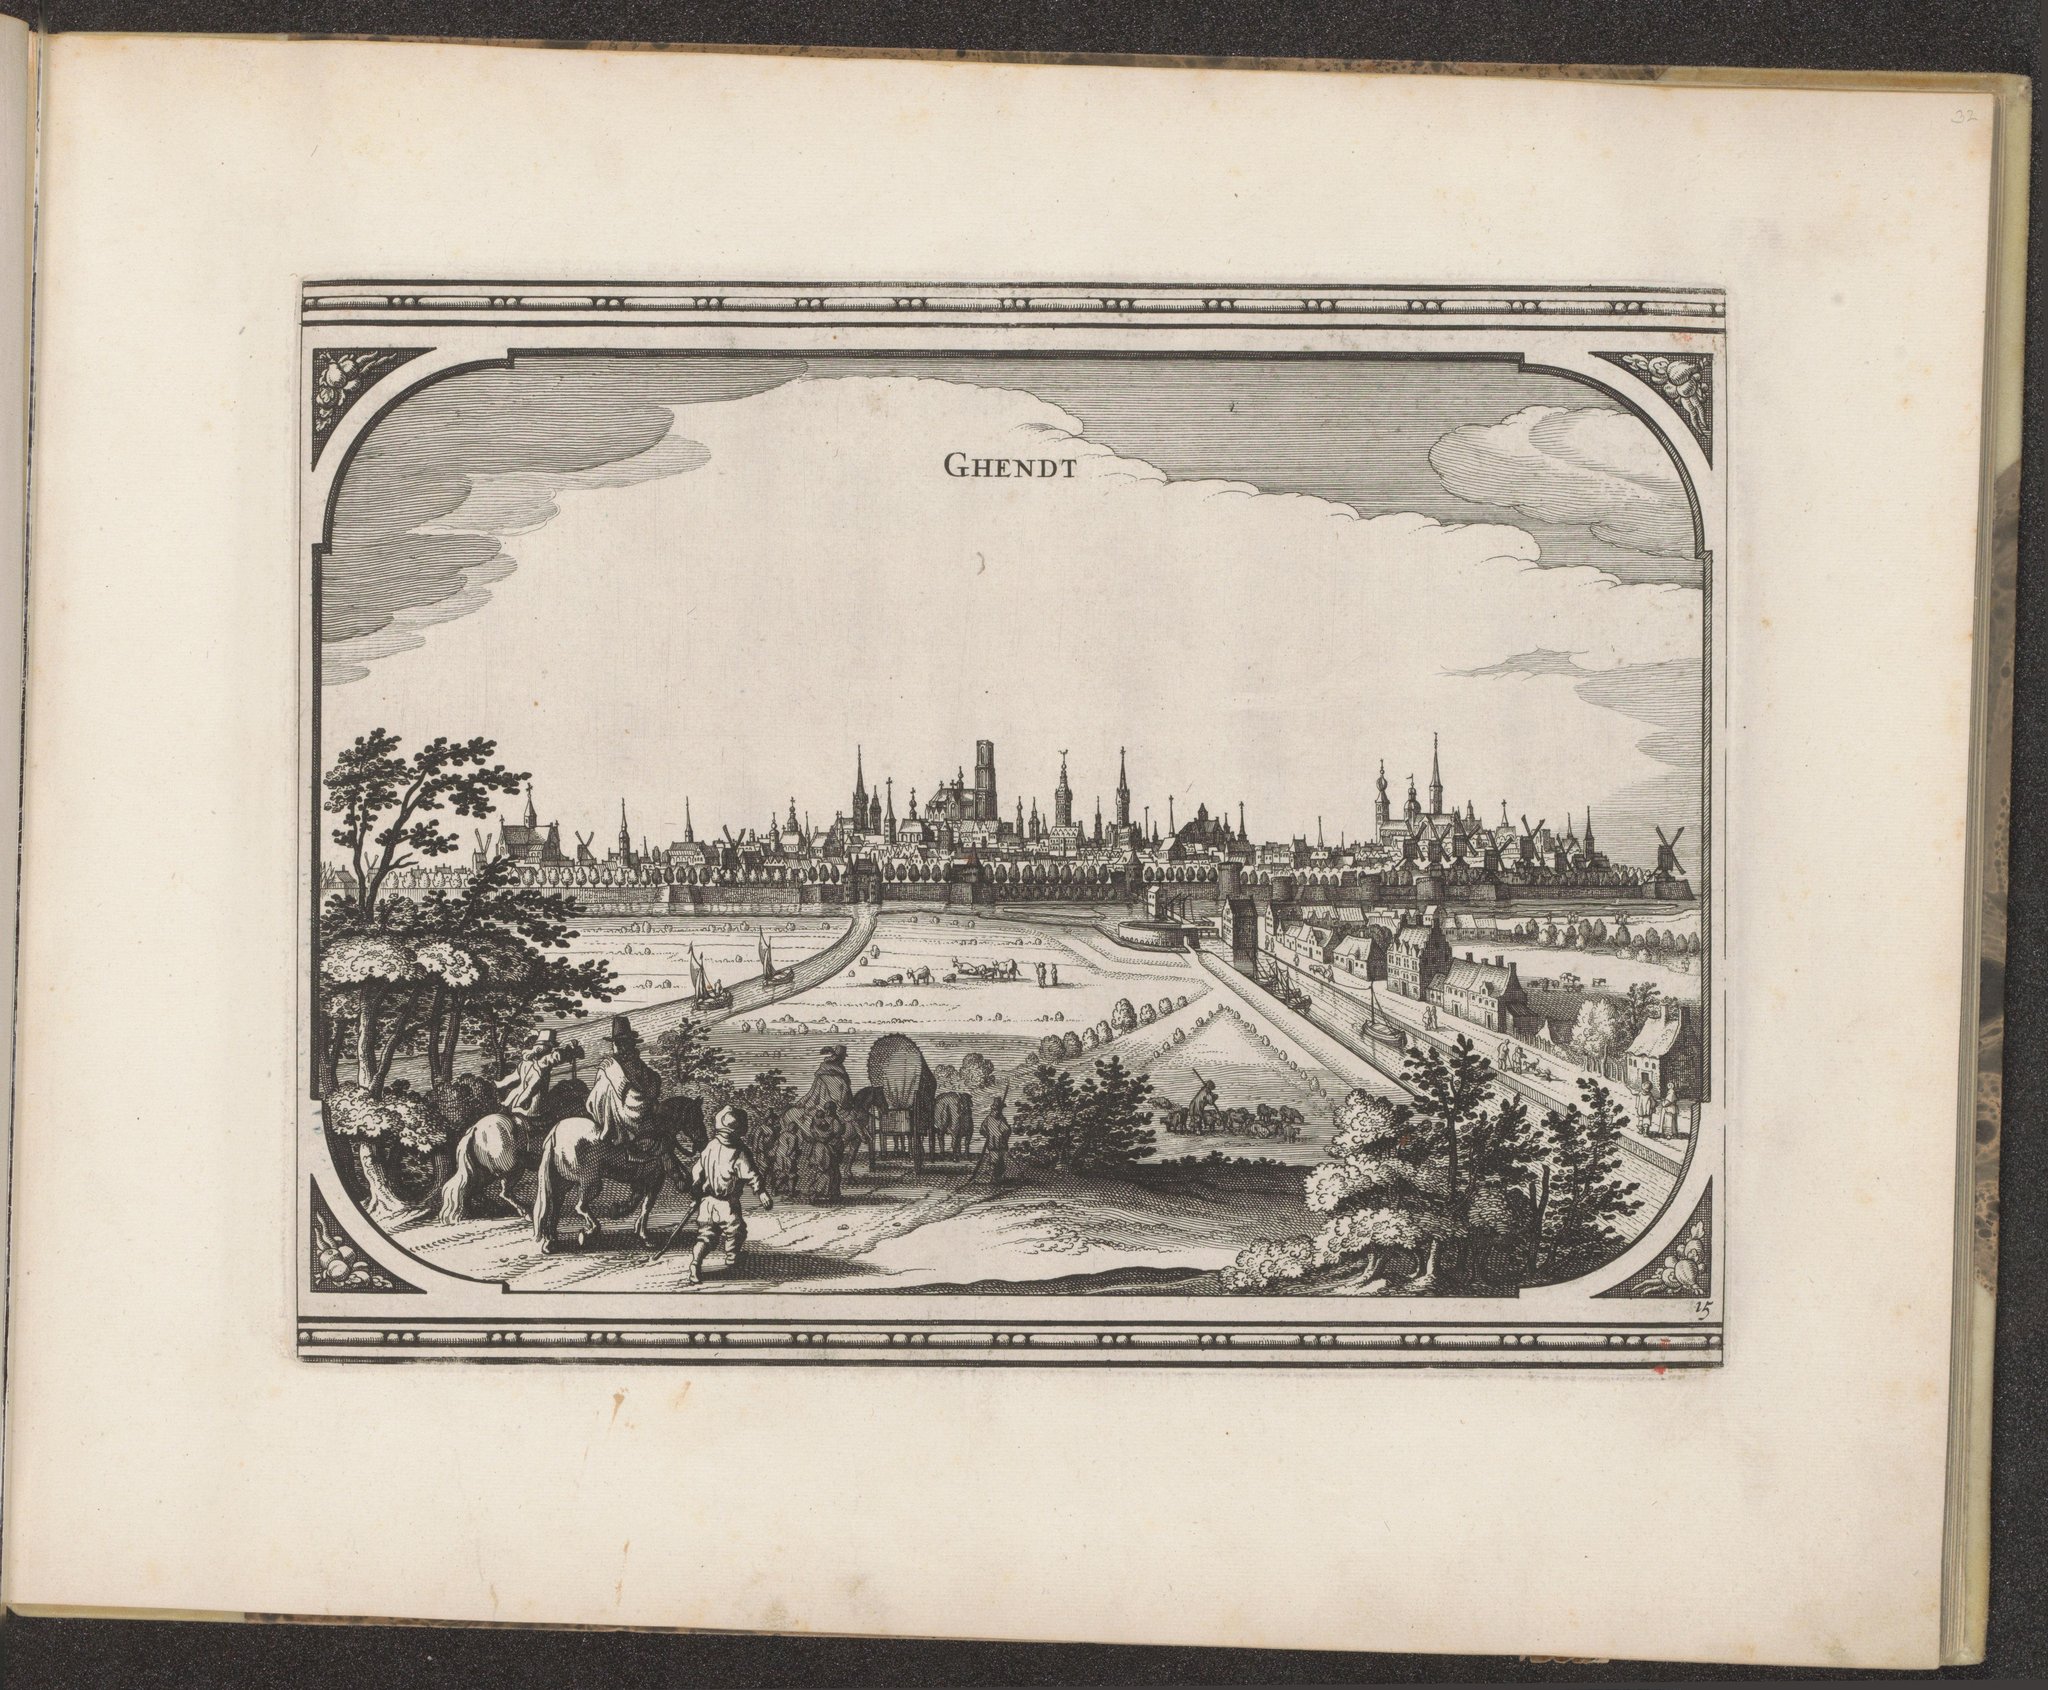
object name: album leaf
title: Ghendt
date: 1660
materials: paper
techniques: etching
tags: city-view, and landscape with man-made constructions, 'en route', traveller under way, ghent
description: Gezicht op de stad Gent met op de voorgrond onder meer enkele ruiters en een huifkar. De prent maakt deel uit van een album.